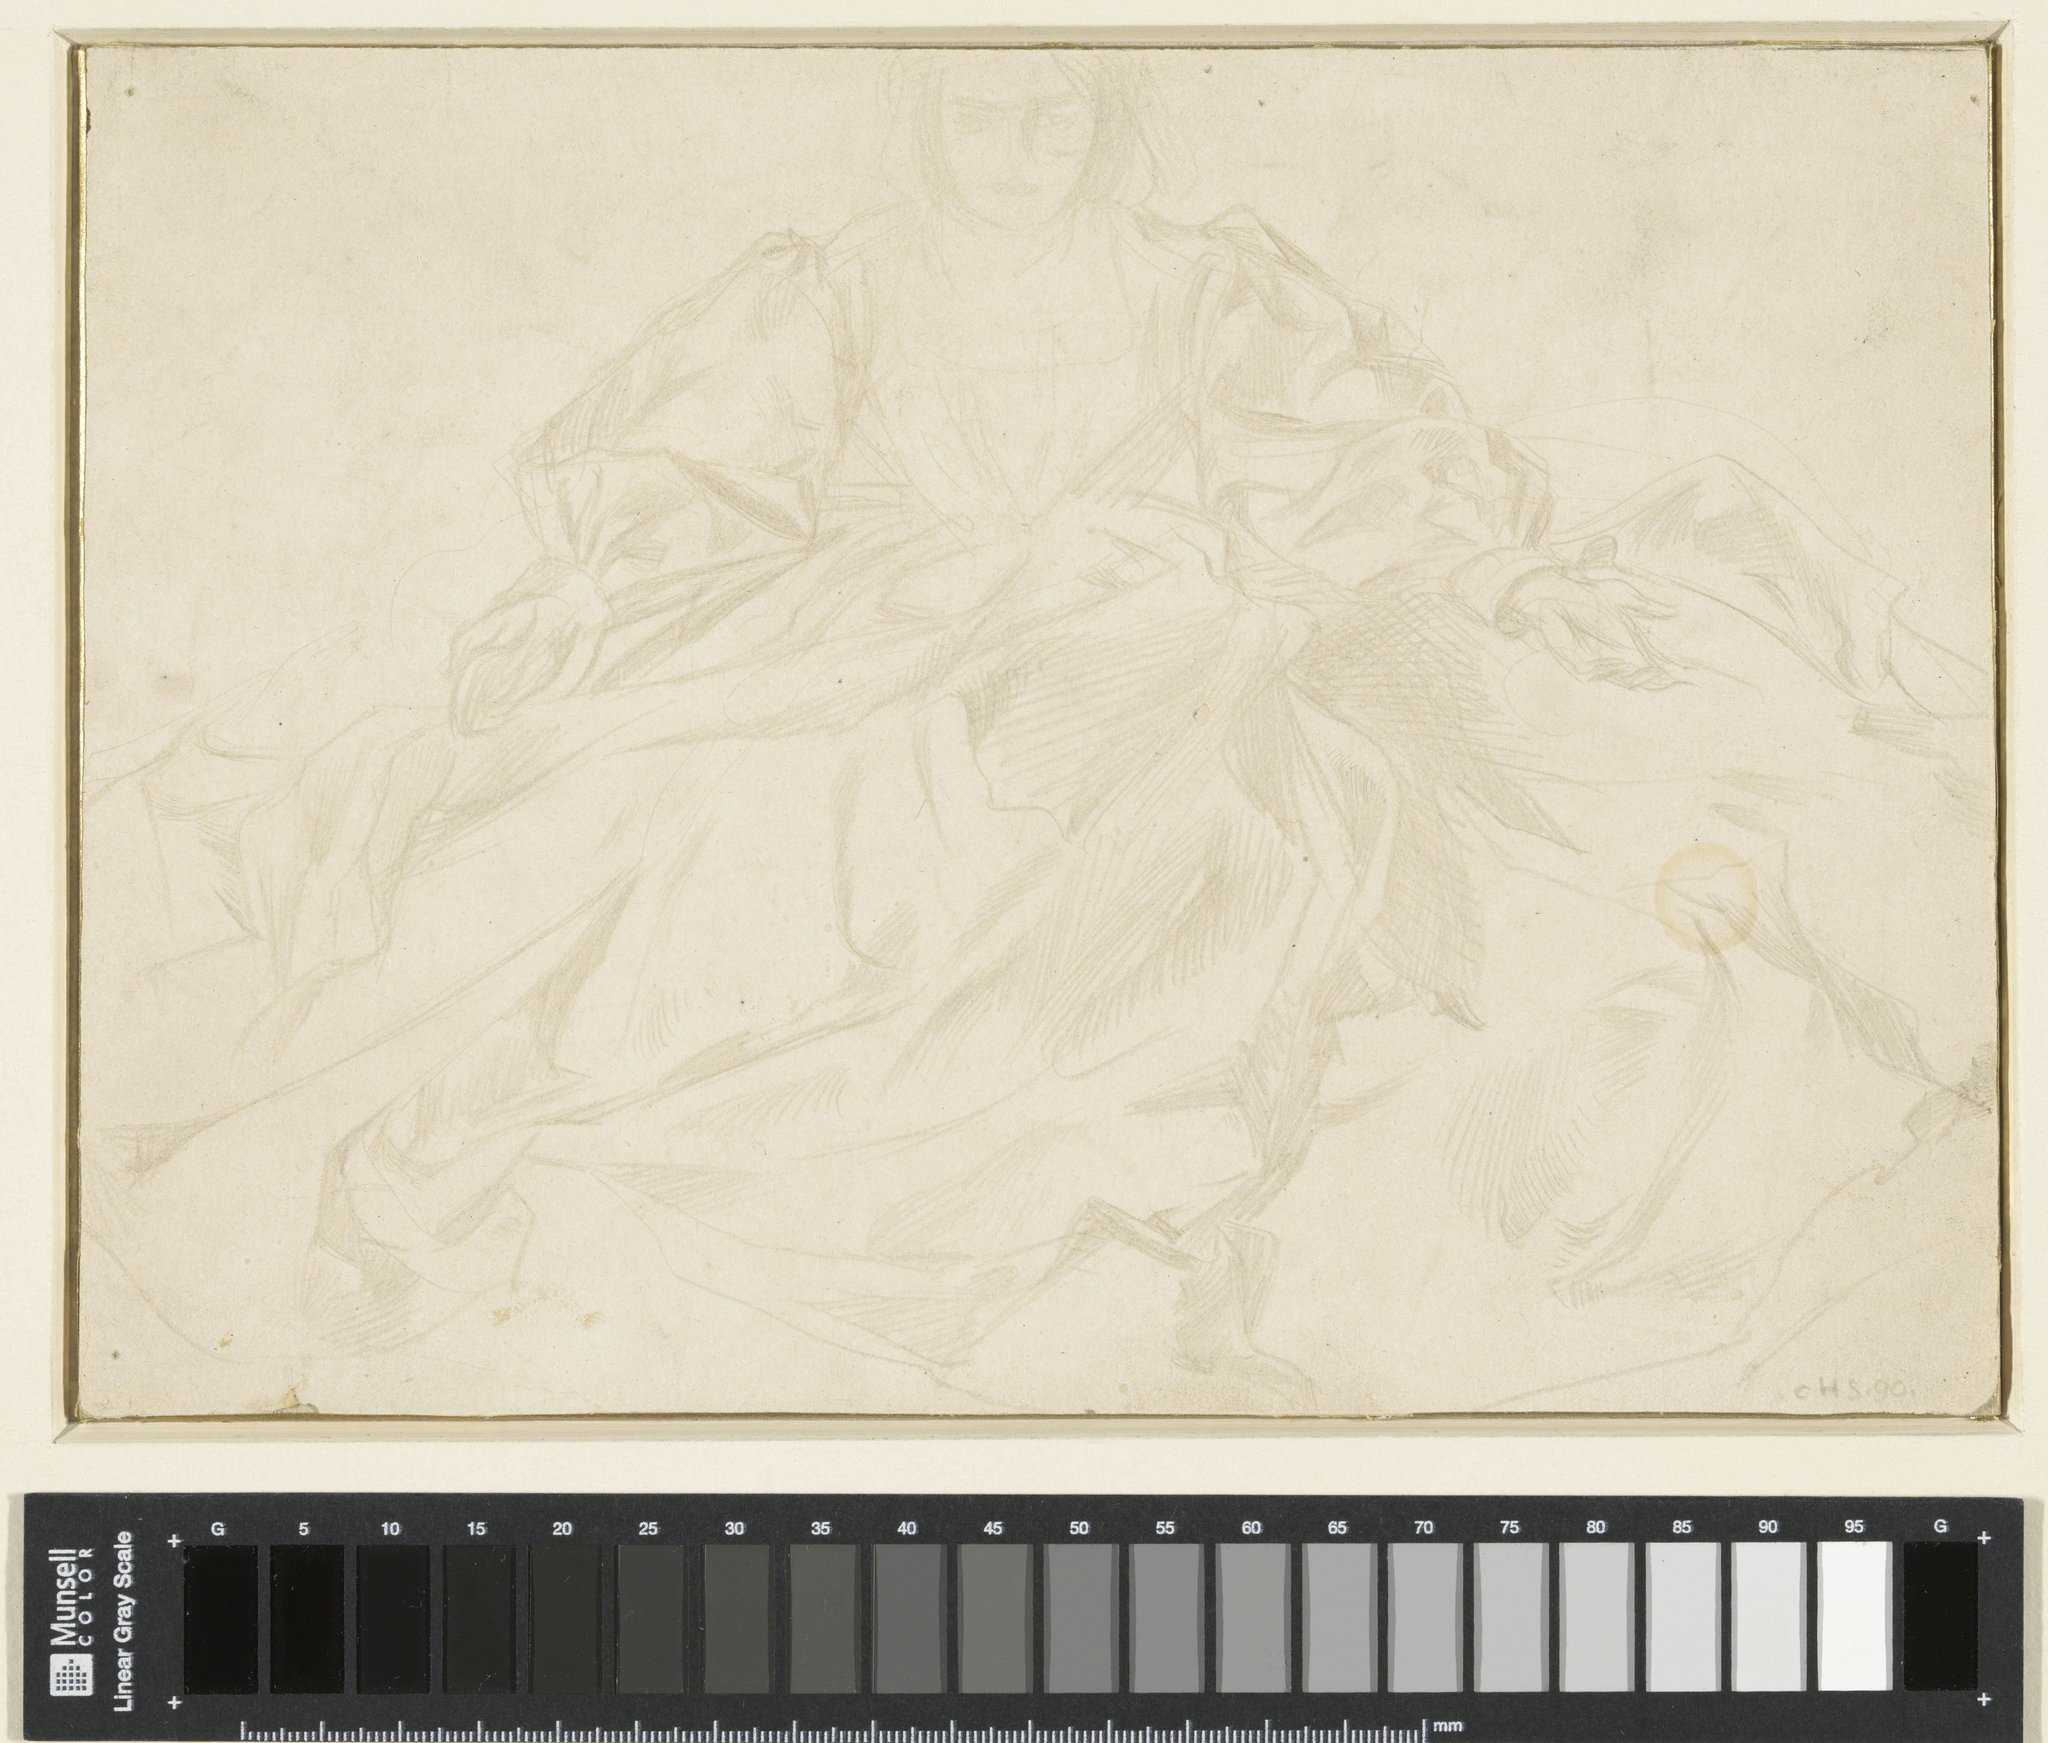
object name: drawing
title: Zittende vrouw met japon en gespreide armen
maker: charles haslewood shannon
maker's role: draughtsman, print maker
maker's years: 1865-1937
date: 1890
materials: paper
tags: sitting figure - aa - female human figure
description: Zittende vrouw, met wijd uitgespreide japon en gespreide armen; het hoofd niet geheel geschetst.